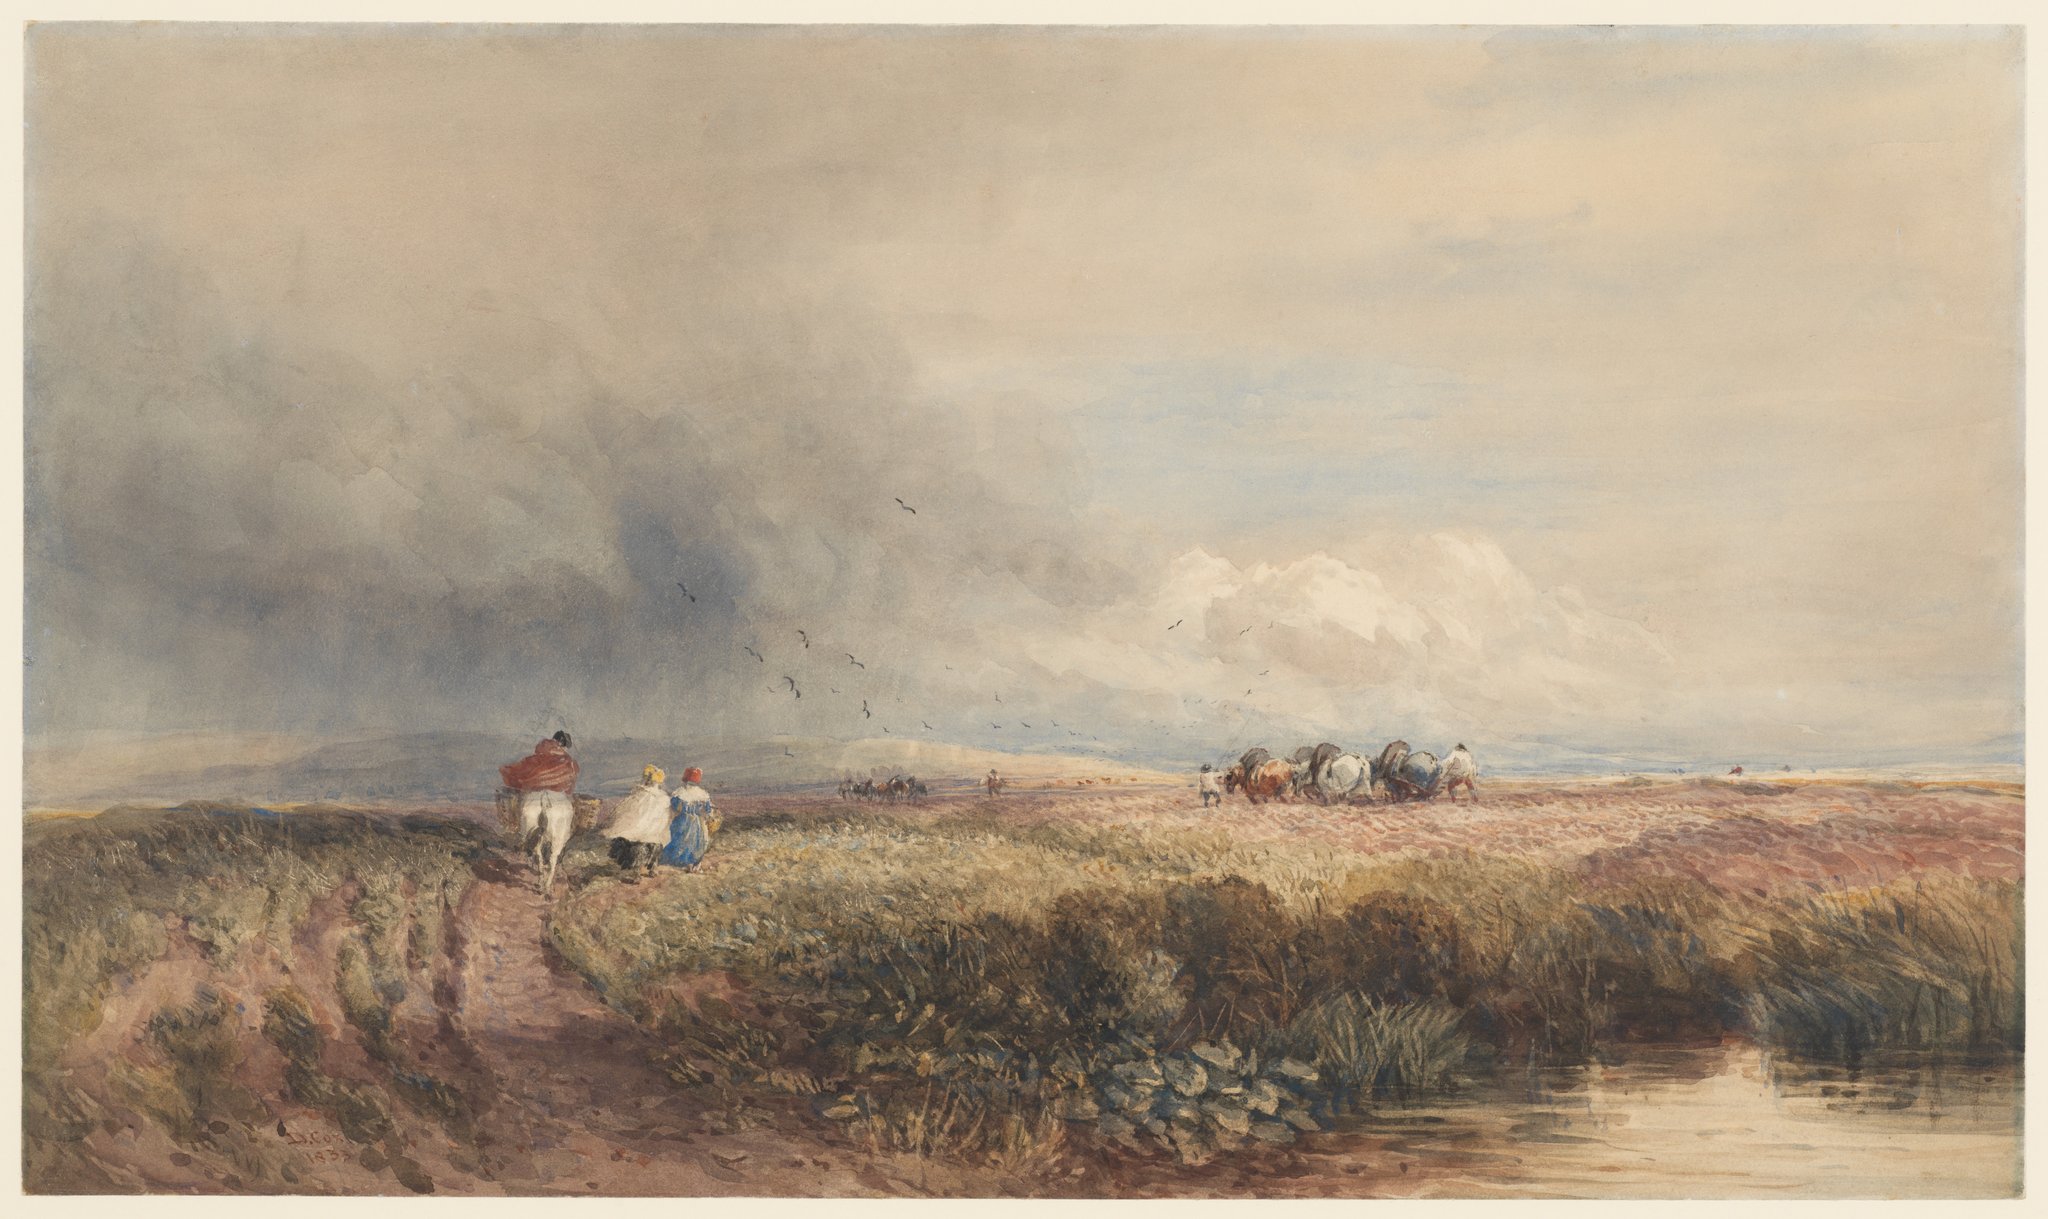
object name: drawing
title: Journey Home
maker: david cox, the elder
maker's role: artist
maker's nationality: english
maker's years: 1783-1859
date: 1833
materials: chalk, watercolor